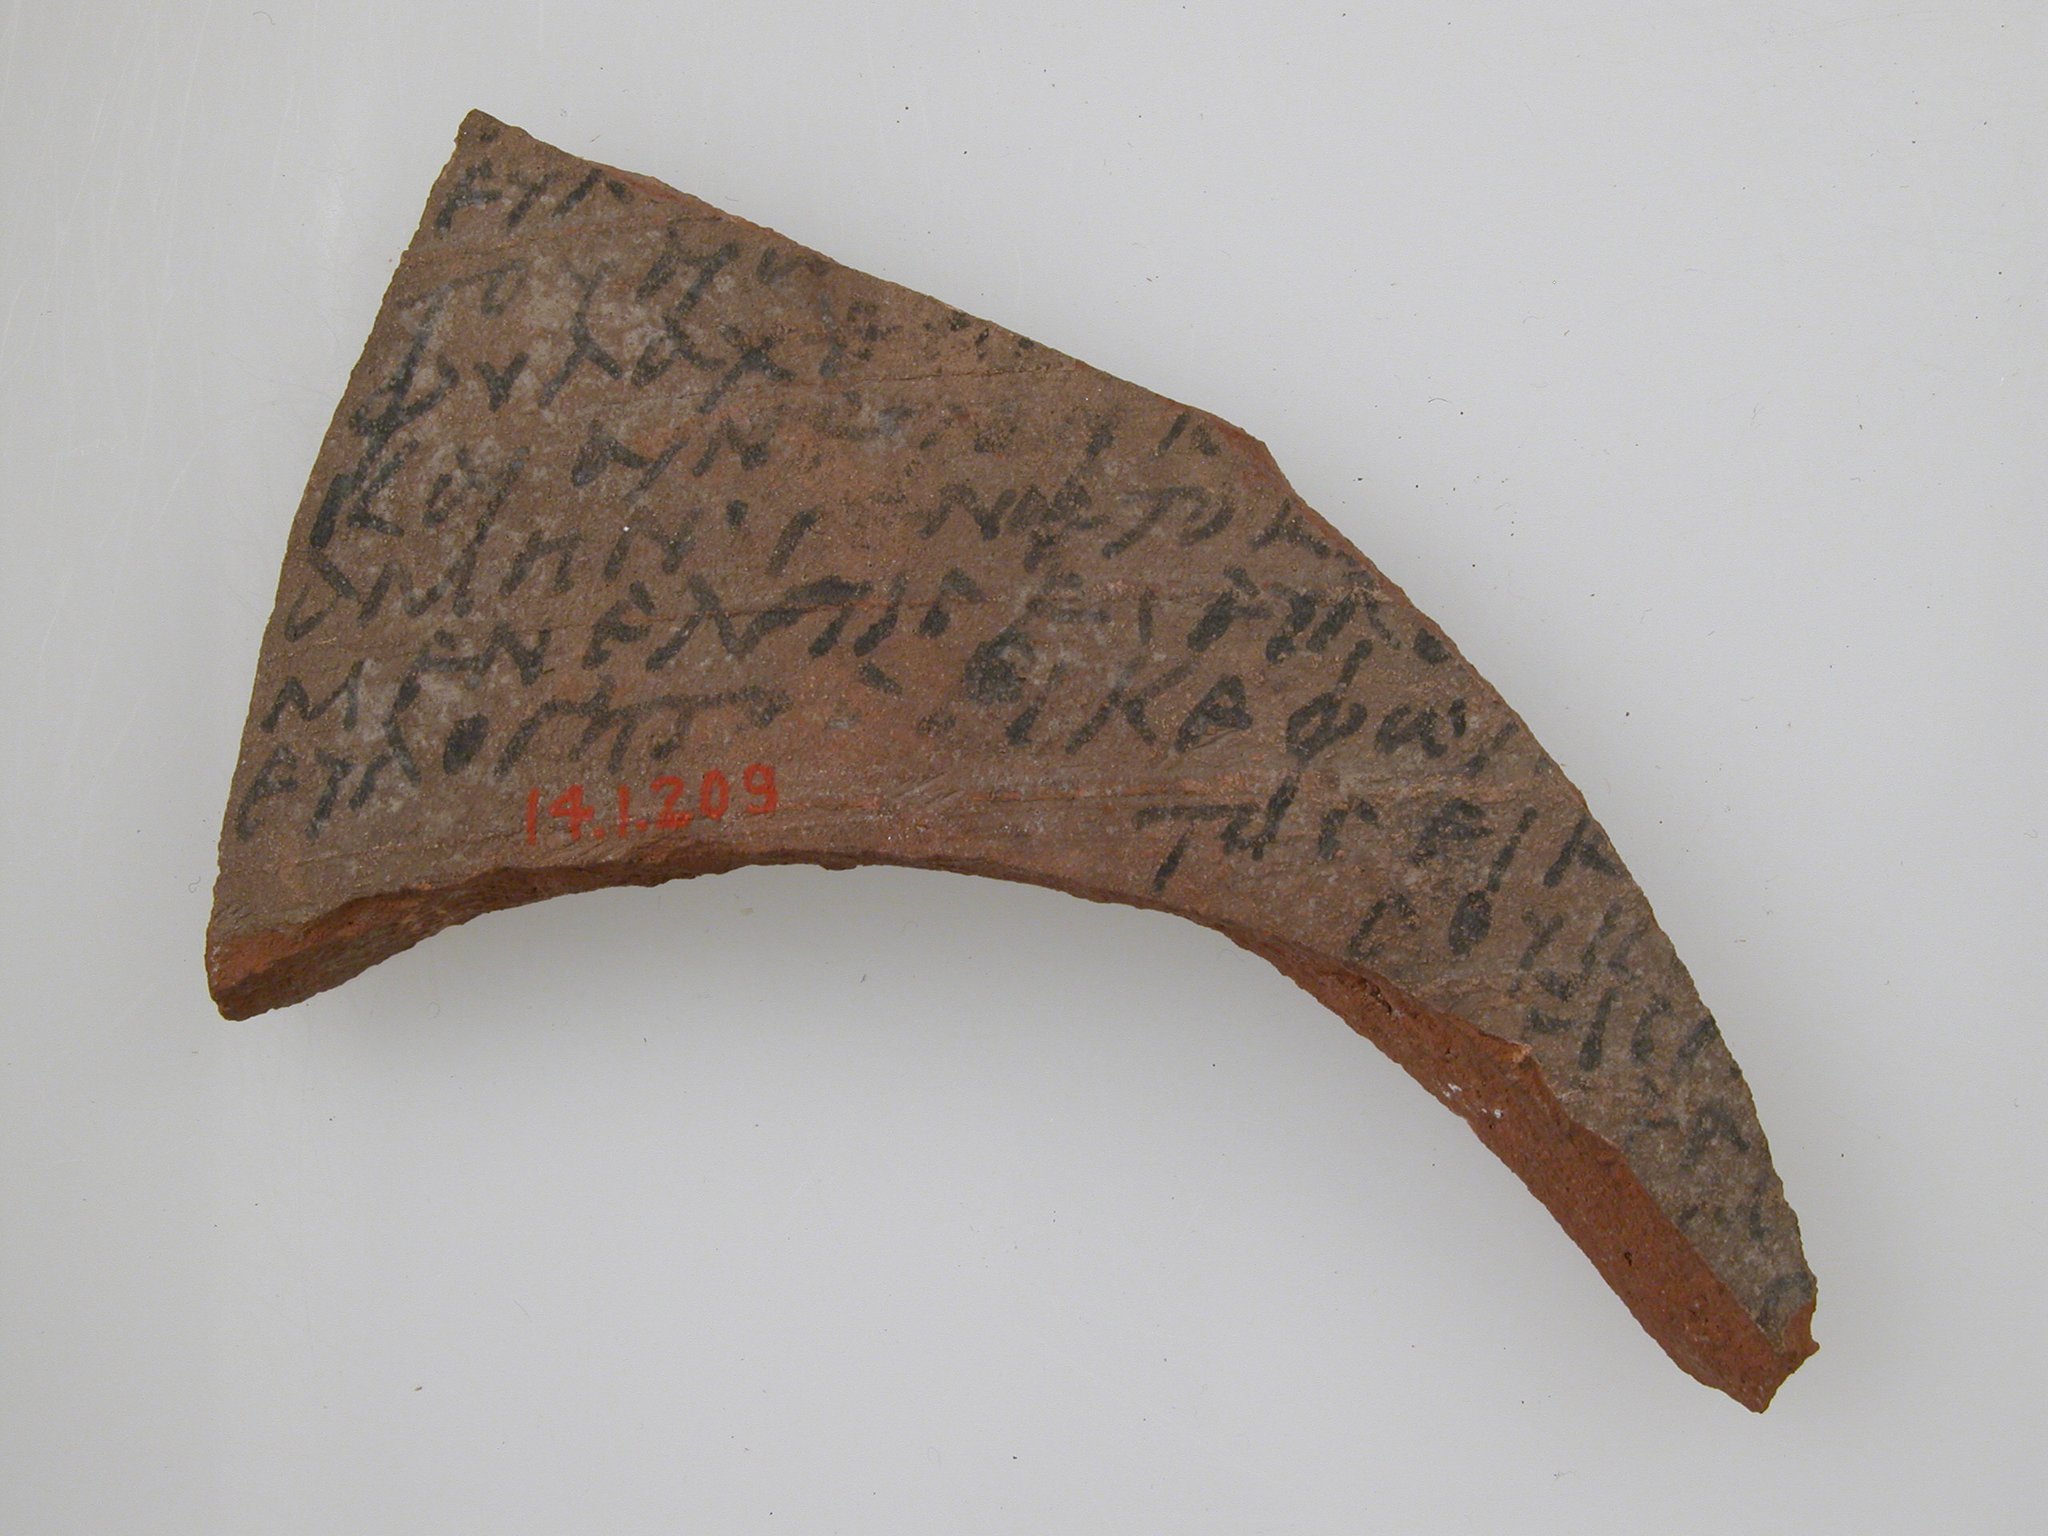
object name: ostrakon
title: Ostrakon with a Canticle (?)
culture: coptic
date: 580-640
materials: ink, pottery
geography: egypt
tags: documents,greek